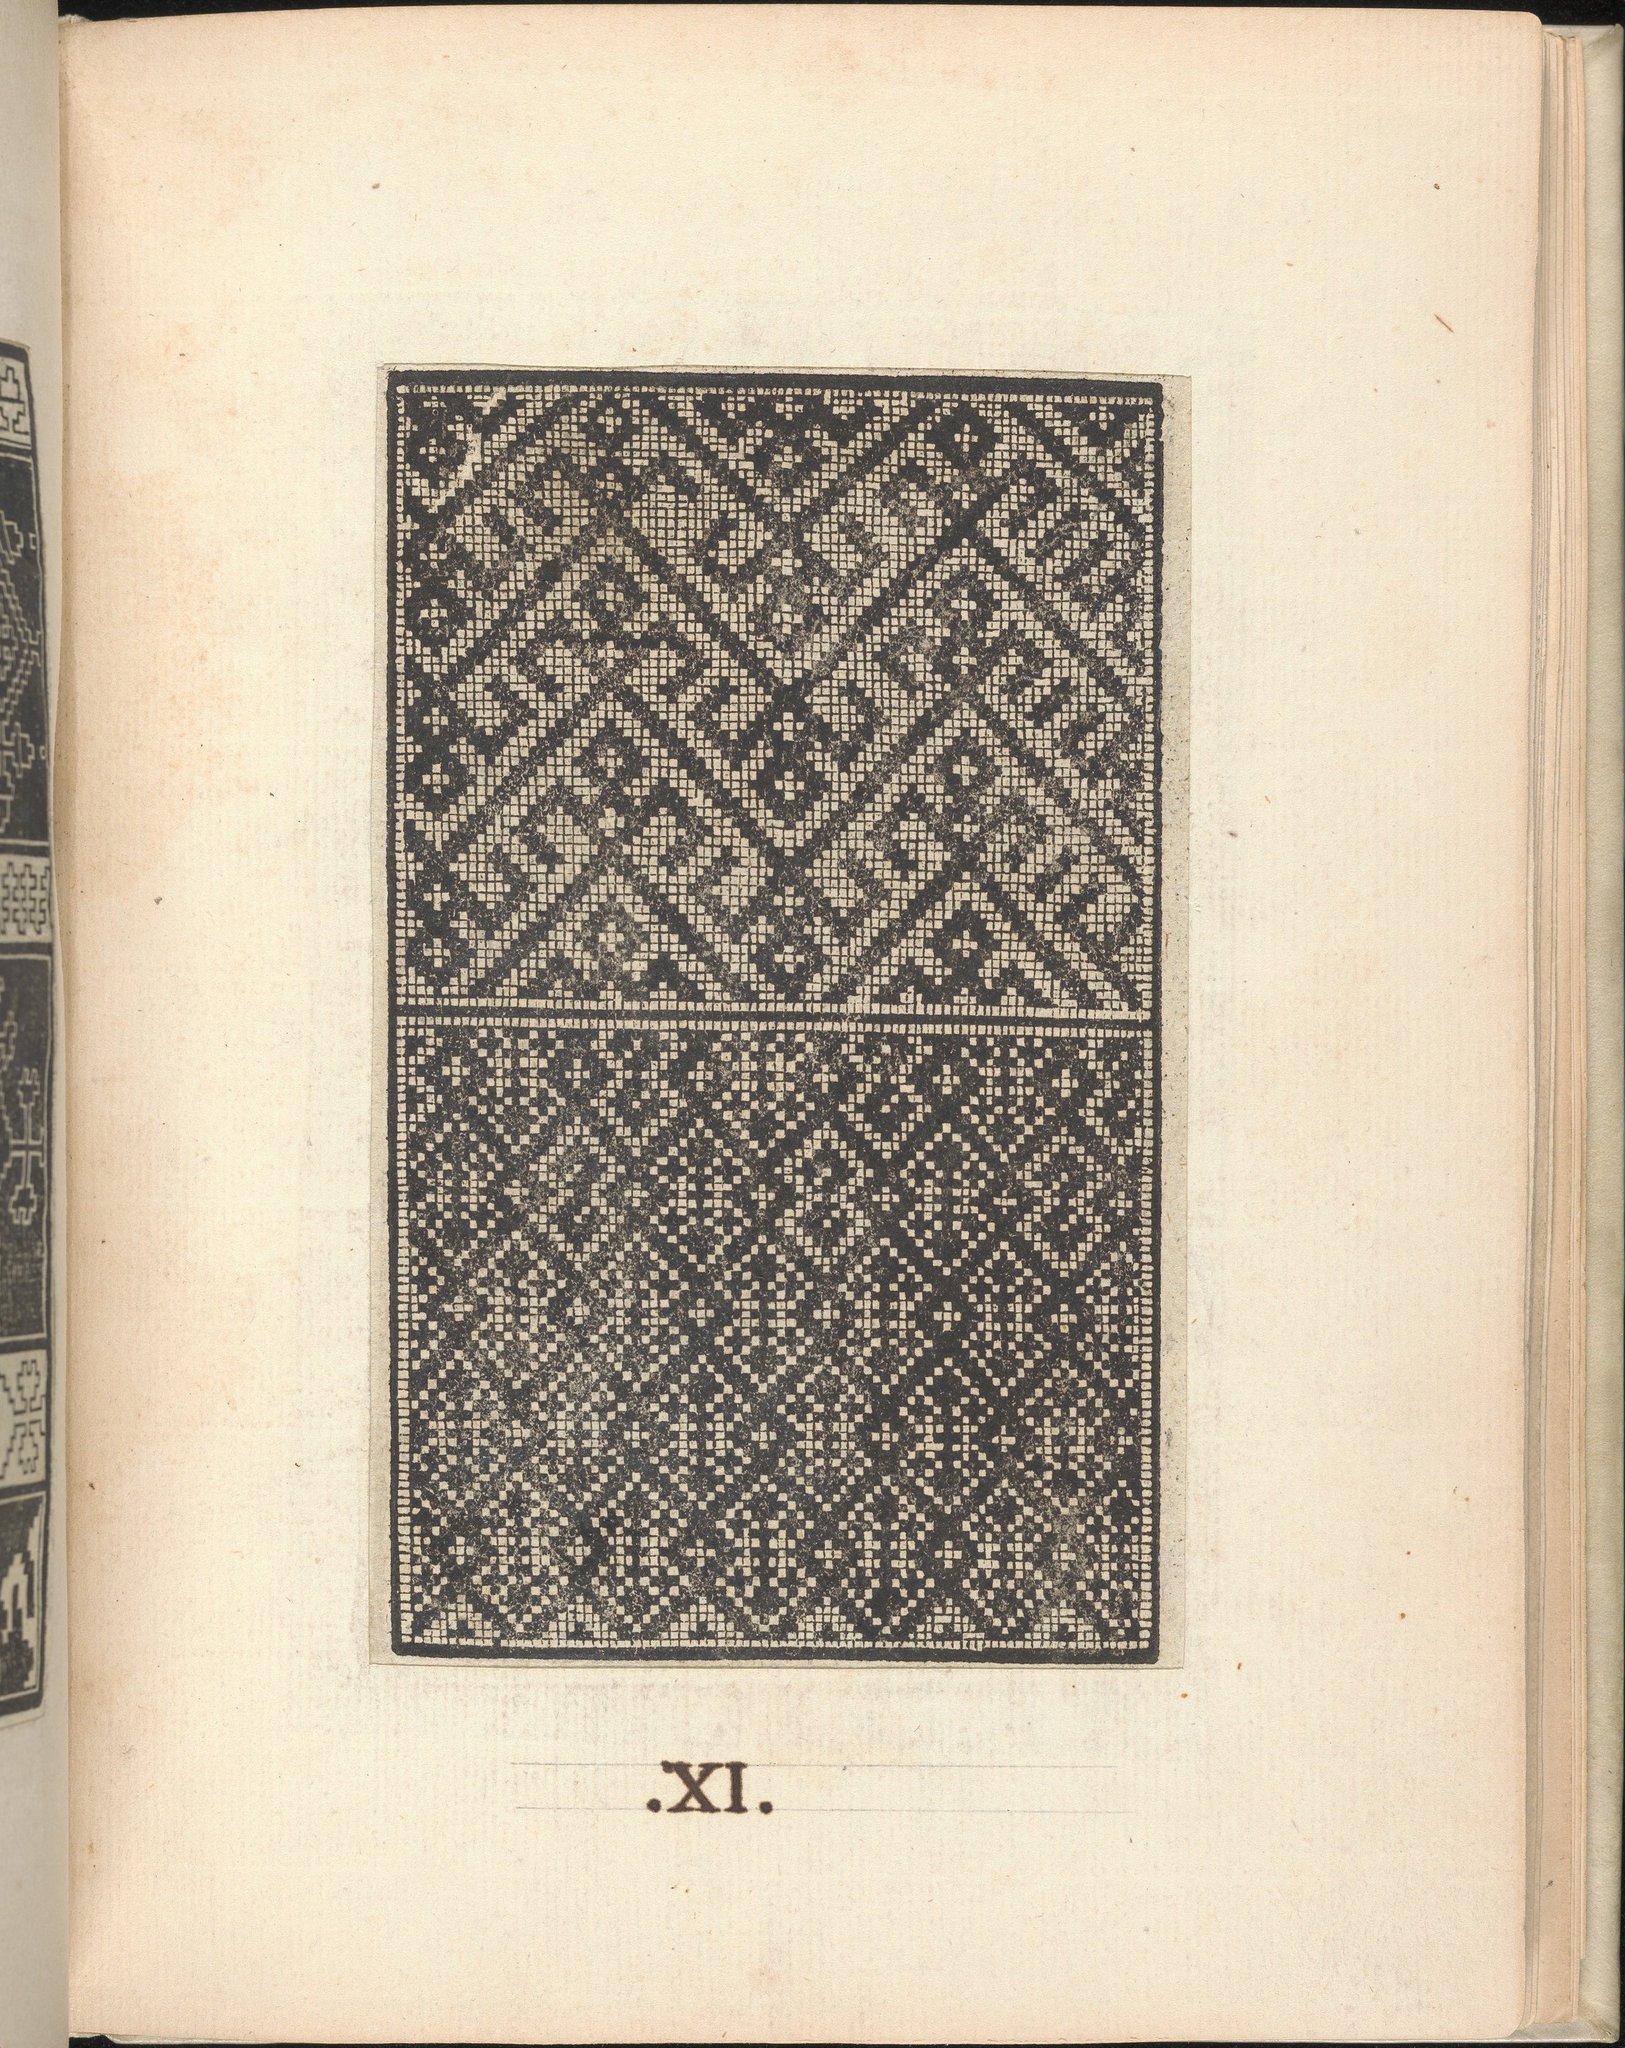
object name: book print ornament architecture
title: Esemplario di lavori, page 11 (recto)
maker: nicolò zoppino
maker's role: publisher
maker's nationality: italian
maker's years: 1478-1544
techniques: bookbinding, inlay, woodcut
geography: italy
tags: ornament